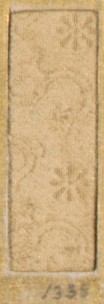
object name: piece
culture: japanese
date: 1701-1900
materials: silk